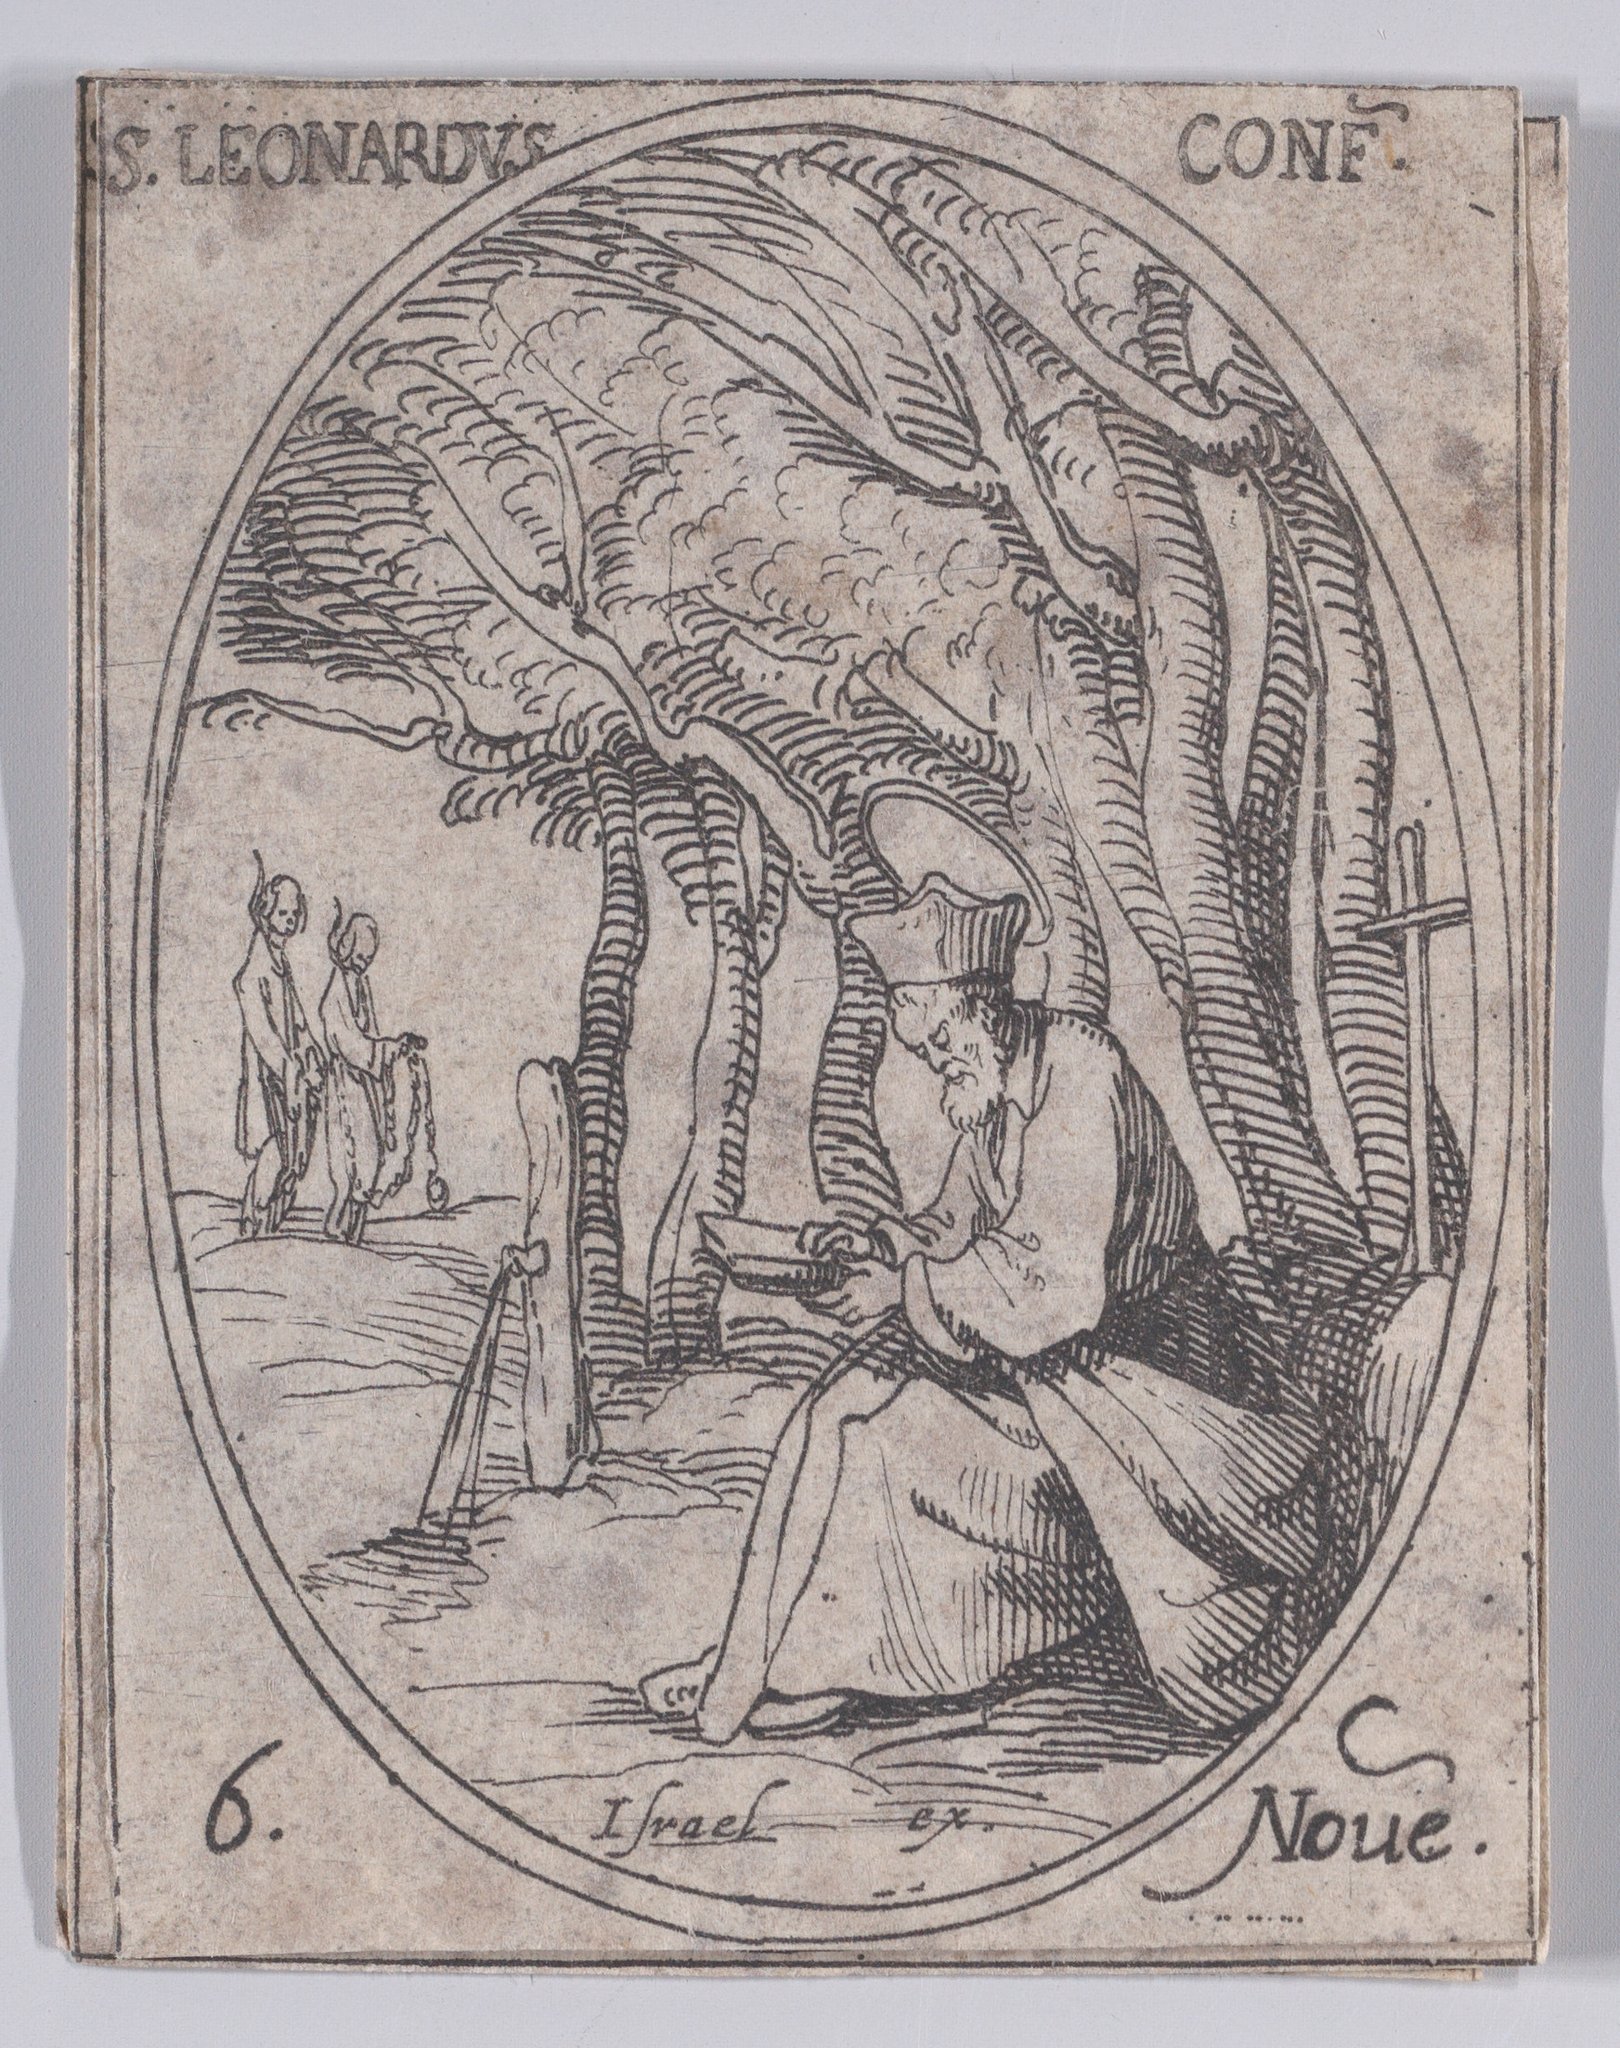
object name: print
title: S. Léonard, confesseur (St. Leonard, Confessor), November 6th, from "Les Images De Tous Les Saincts et Saintes de L'Année" (Images of All of the Saints and Religious Events of the Year)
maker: jacques callot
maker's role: artist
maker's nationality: french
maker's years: 1592-1635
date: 1636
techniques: etching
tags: men,saints